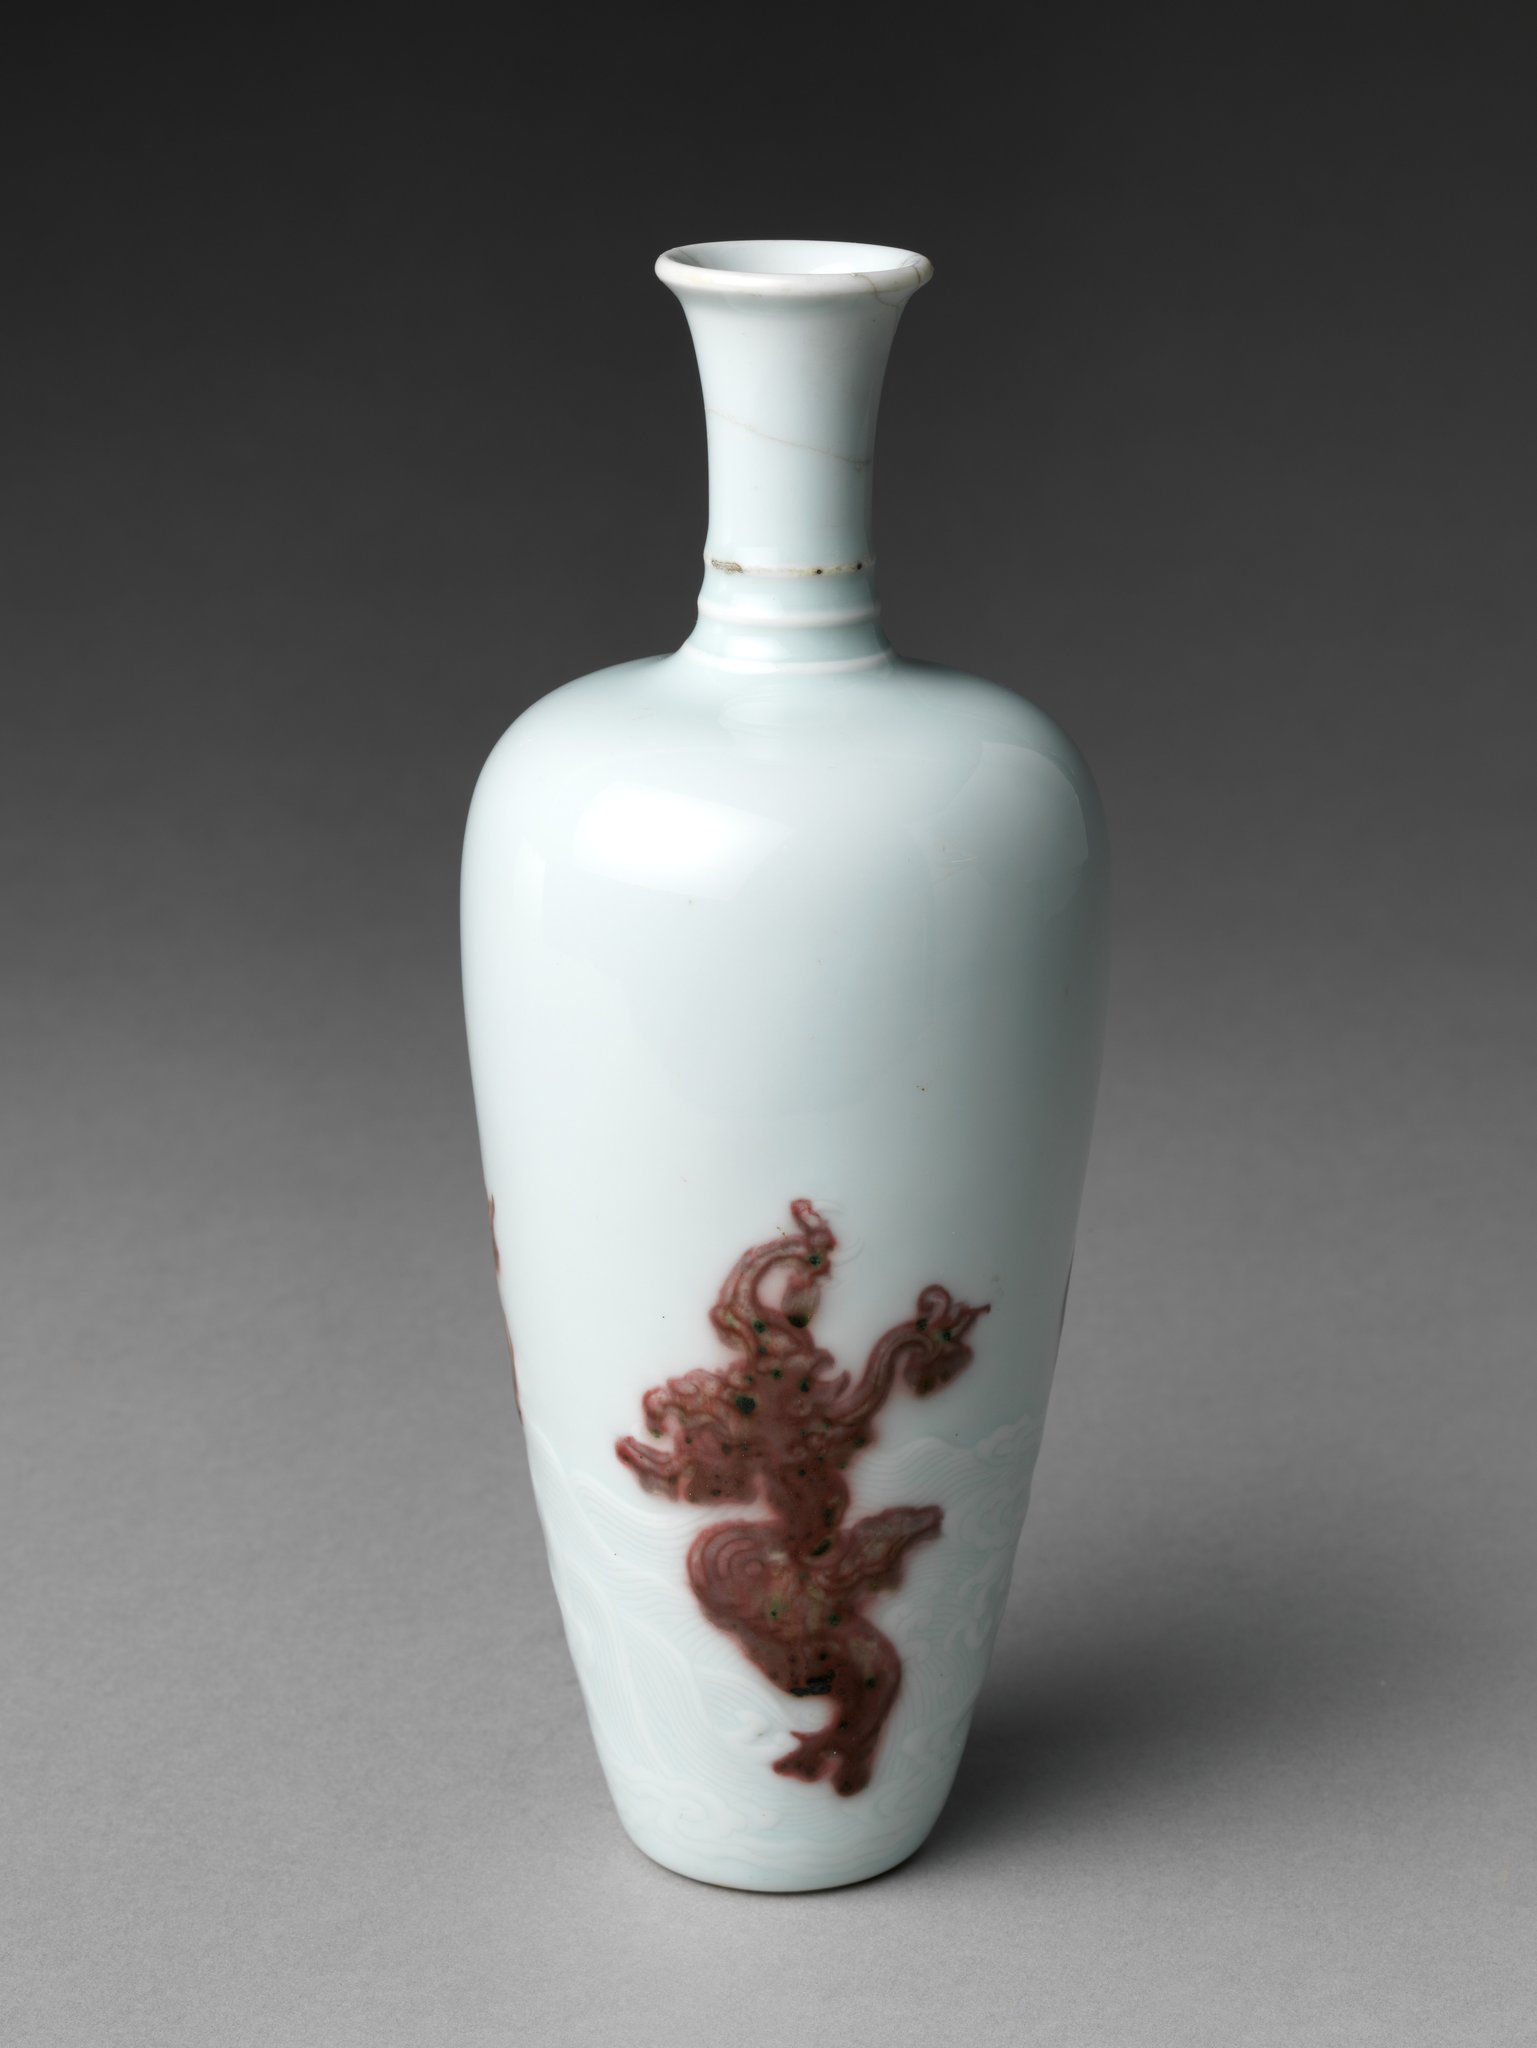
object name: vase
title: Vase with Dragon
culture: chinese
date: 1678-1712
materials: copper, glaze, porcelain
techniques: painting, relief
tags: dragons